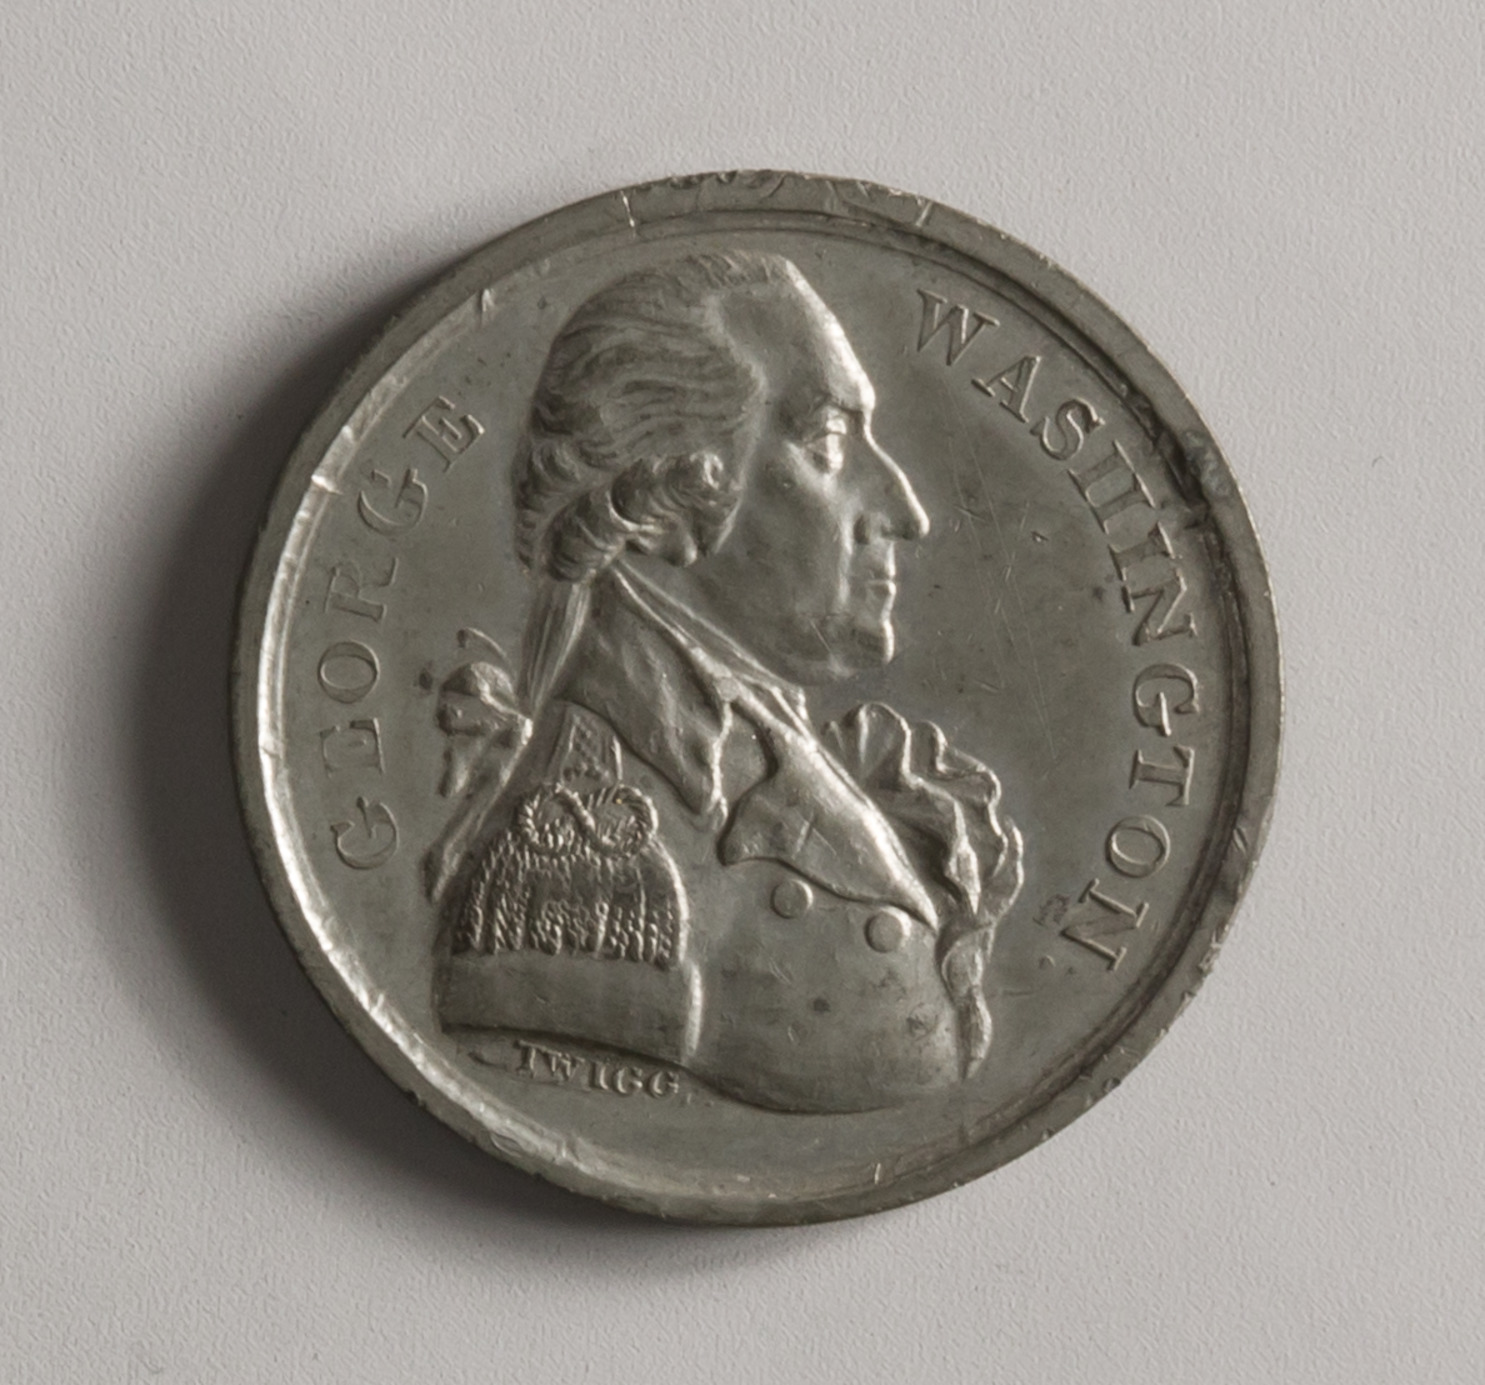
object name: medal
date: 1789-1800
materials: metal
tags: george washington,profiles